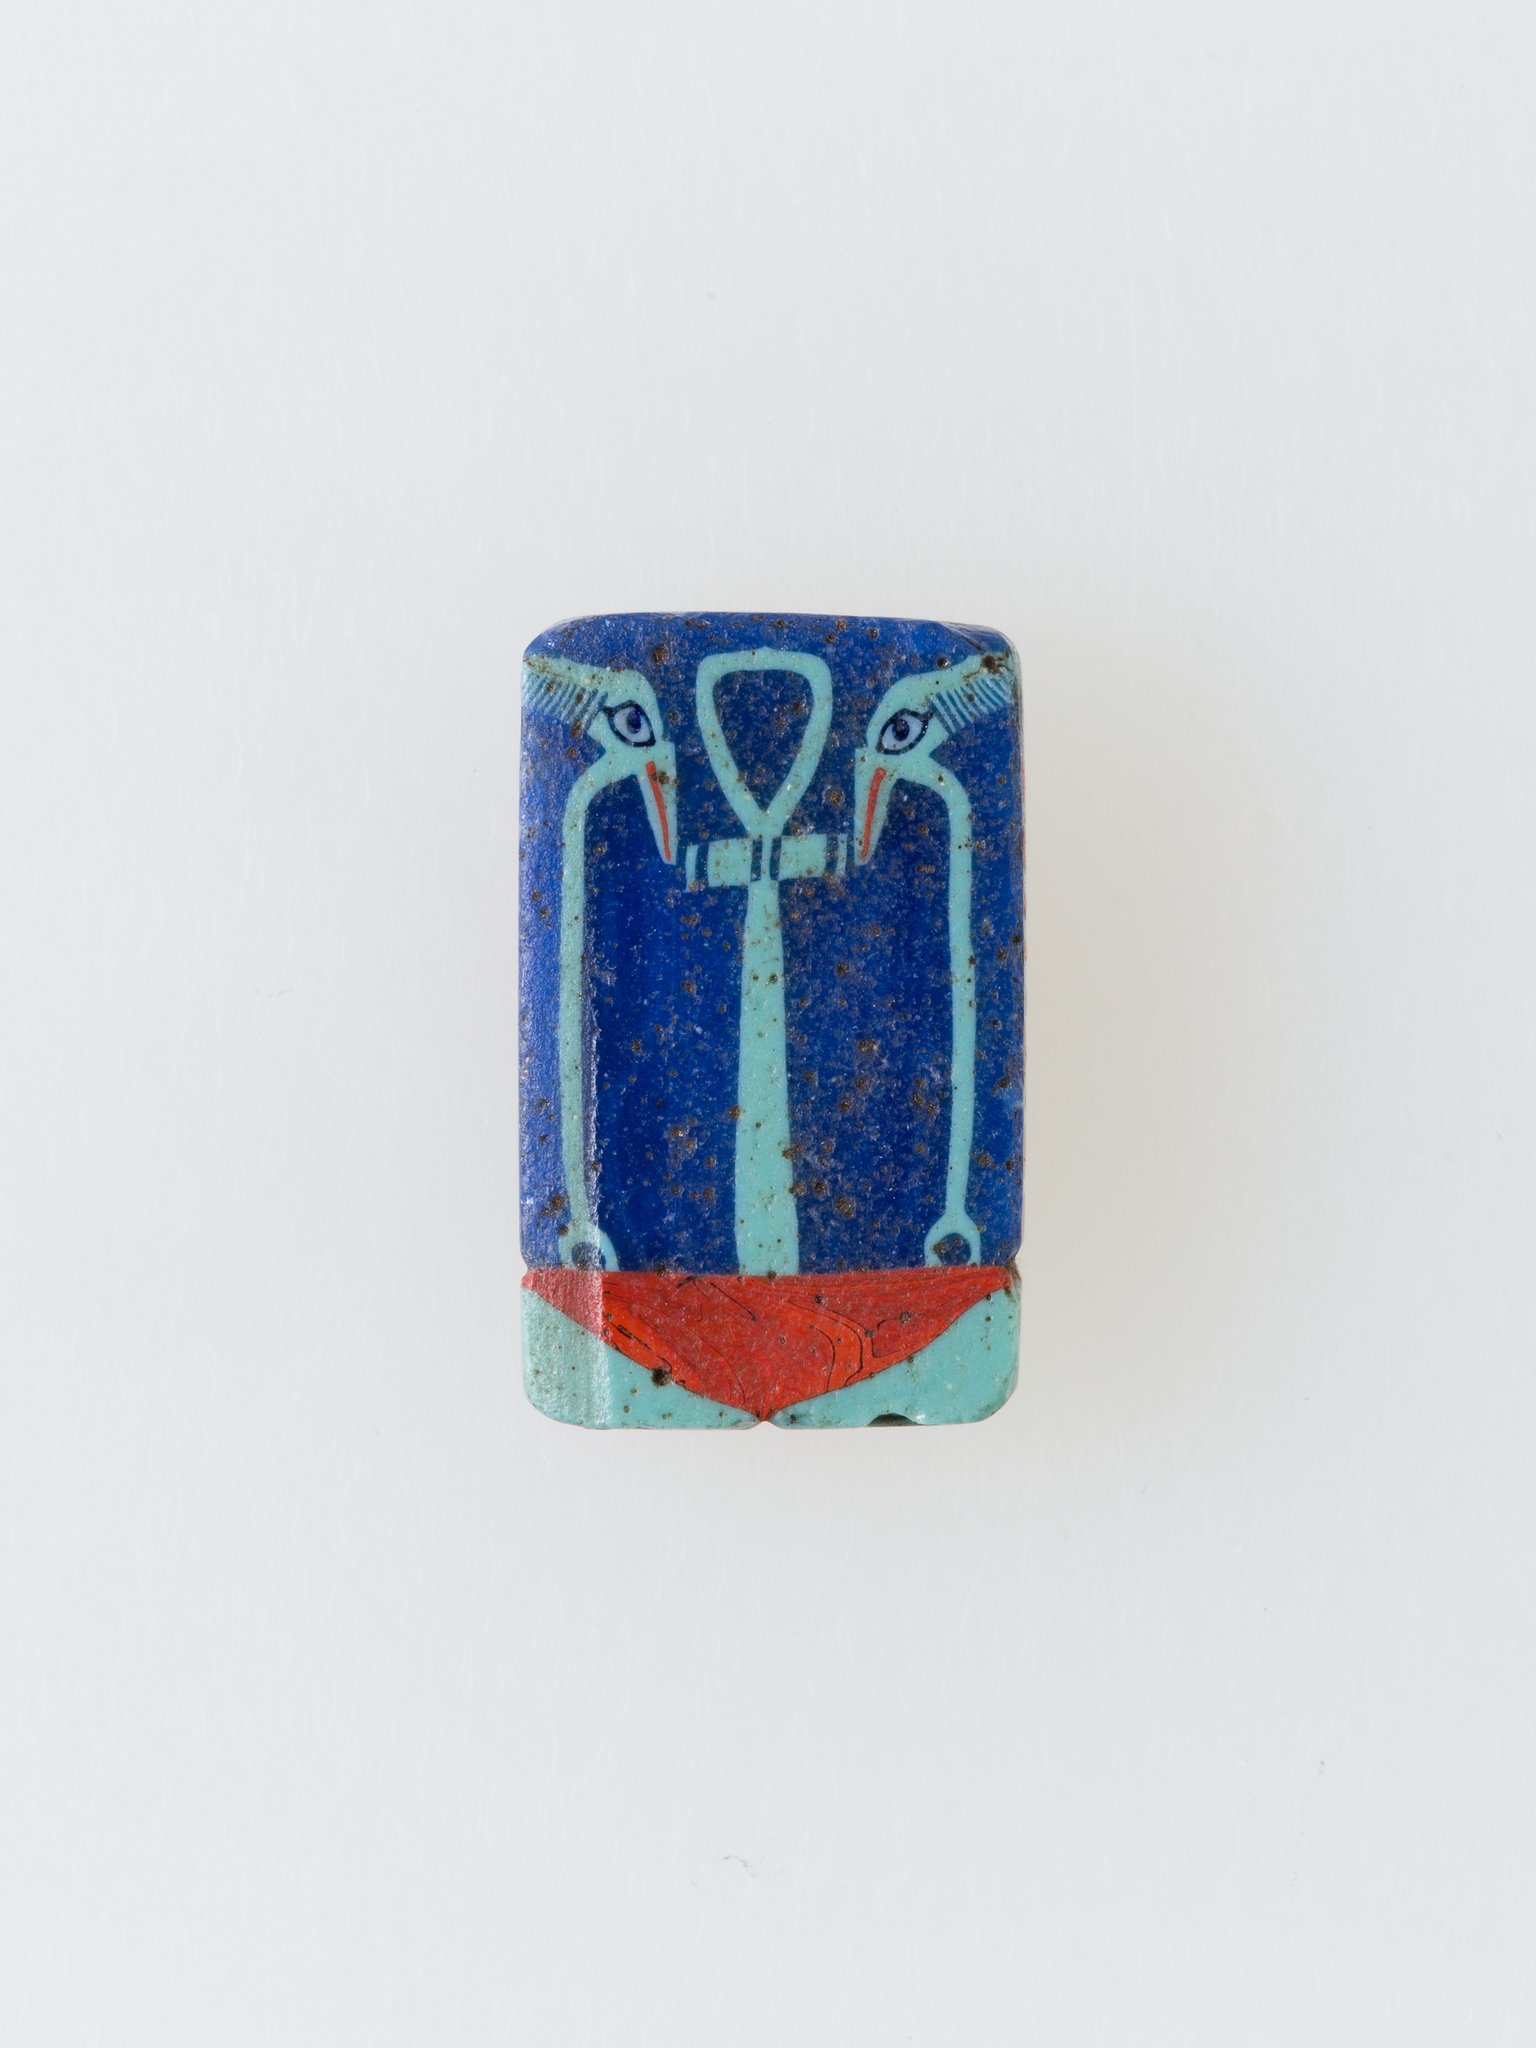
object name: inlay, ankh, wa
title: Inlay, ankh with was scepters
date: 100 BCE-100 CE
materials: glass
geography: egypt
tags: ankh